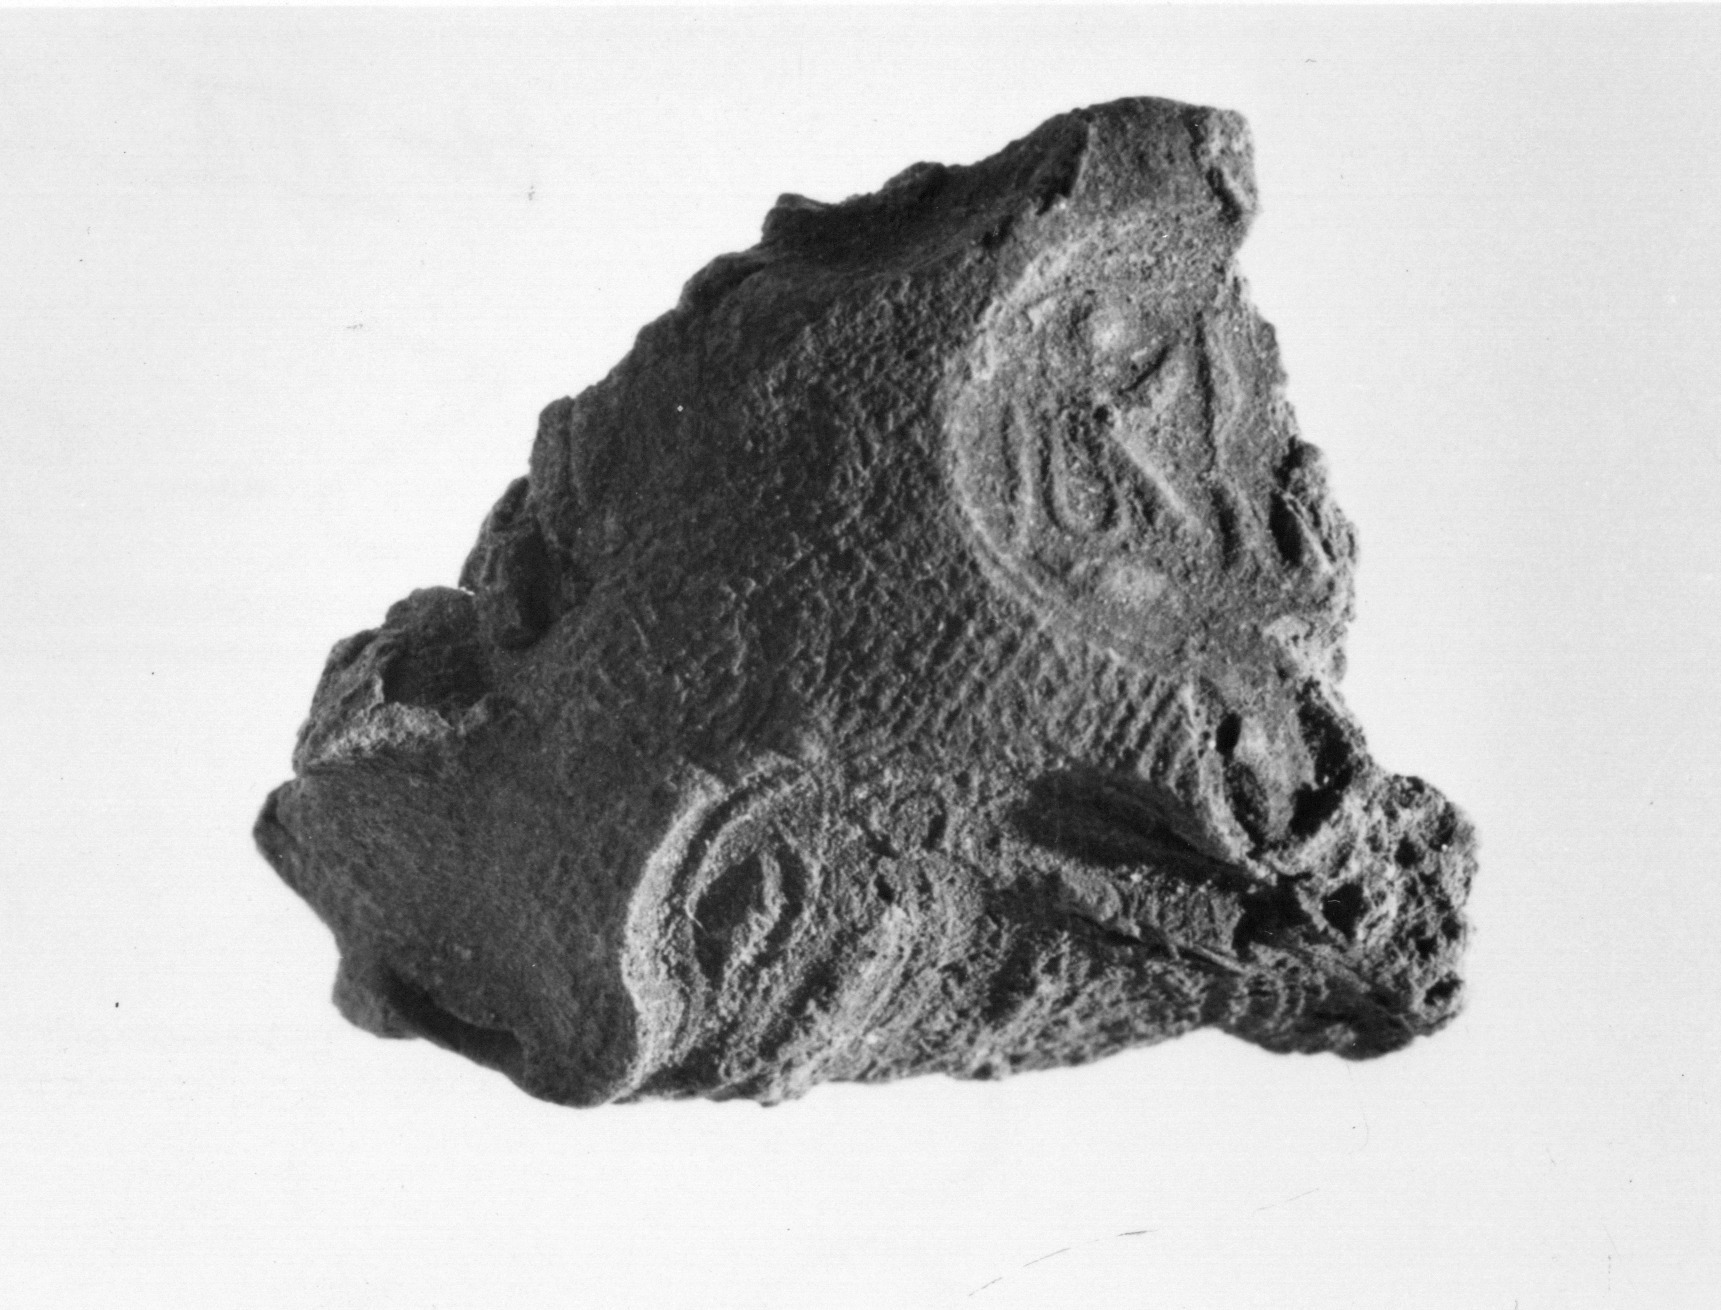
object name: sealing, amenhotep iii, nebmaatre. winged cobra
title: Document Sealing With the Throne Name of Amenhotep III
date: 1390-1352 BCE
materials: mud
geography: egypt